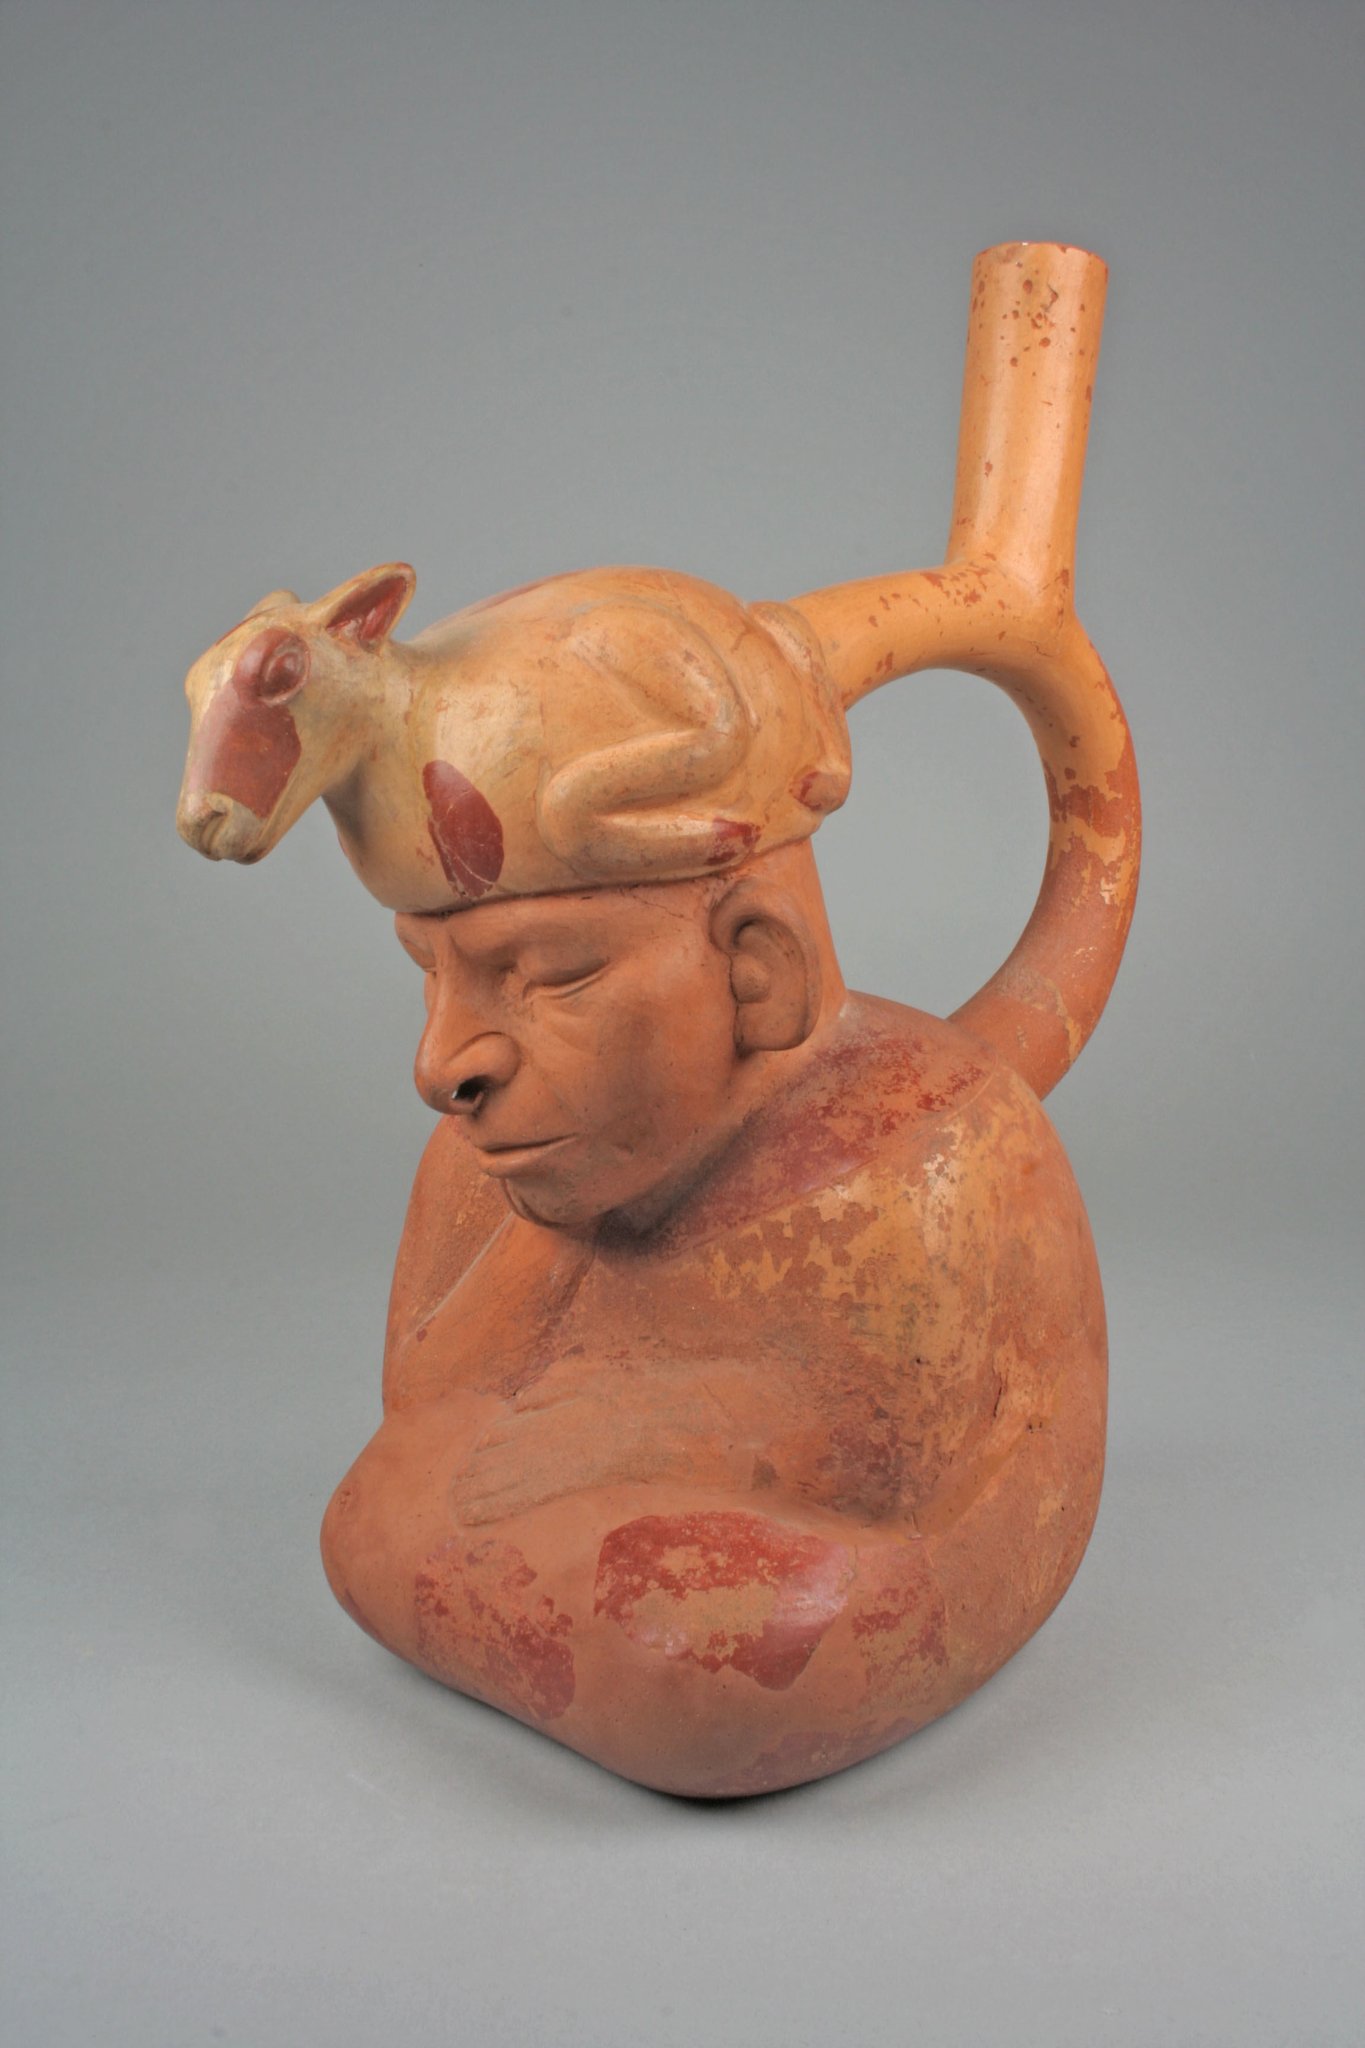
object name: bottle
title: Stirrup spout bottle with figure with llama headdress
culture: moche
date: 201-600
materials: ceramic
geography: peru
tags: animals,heads